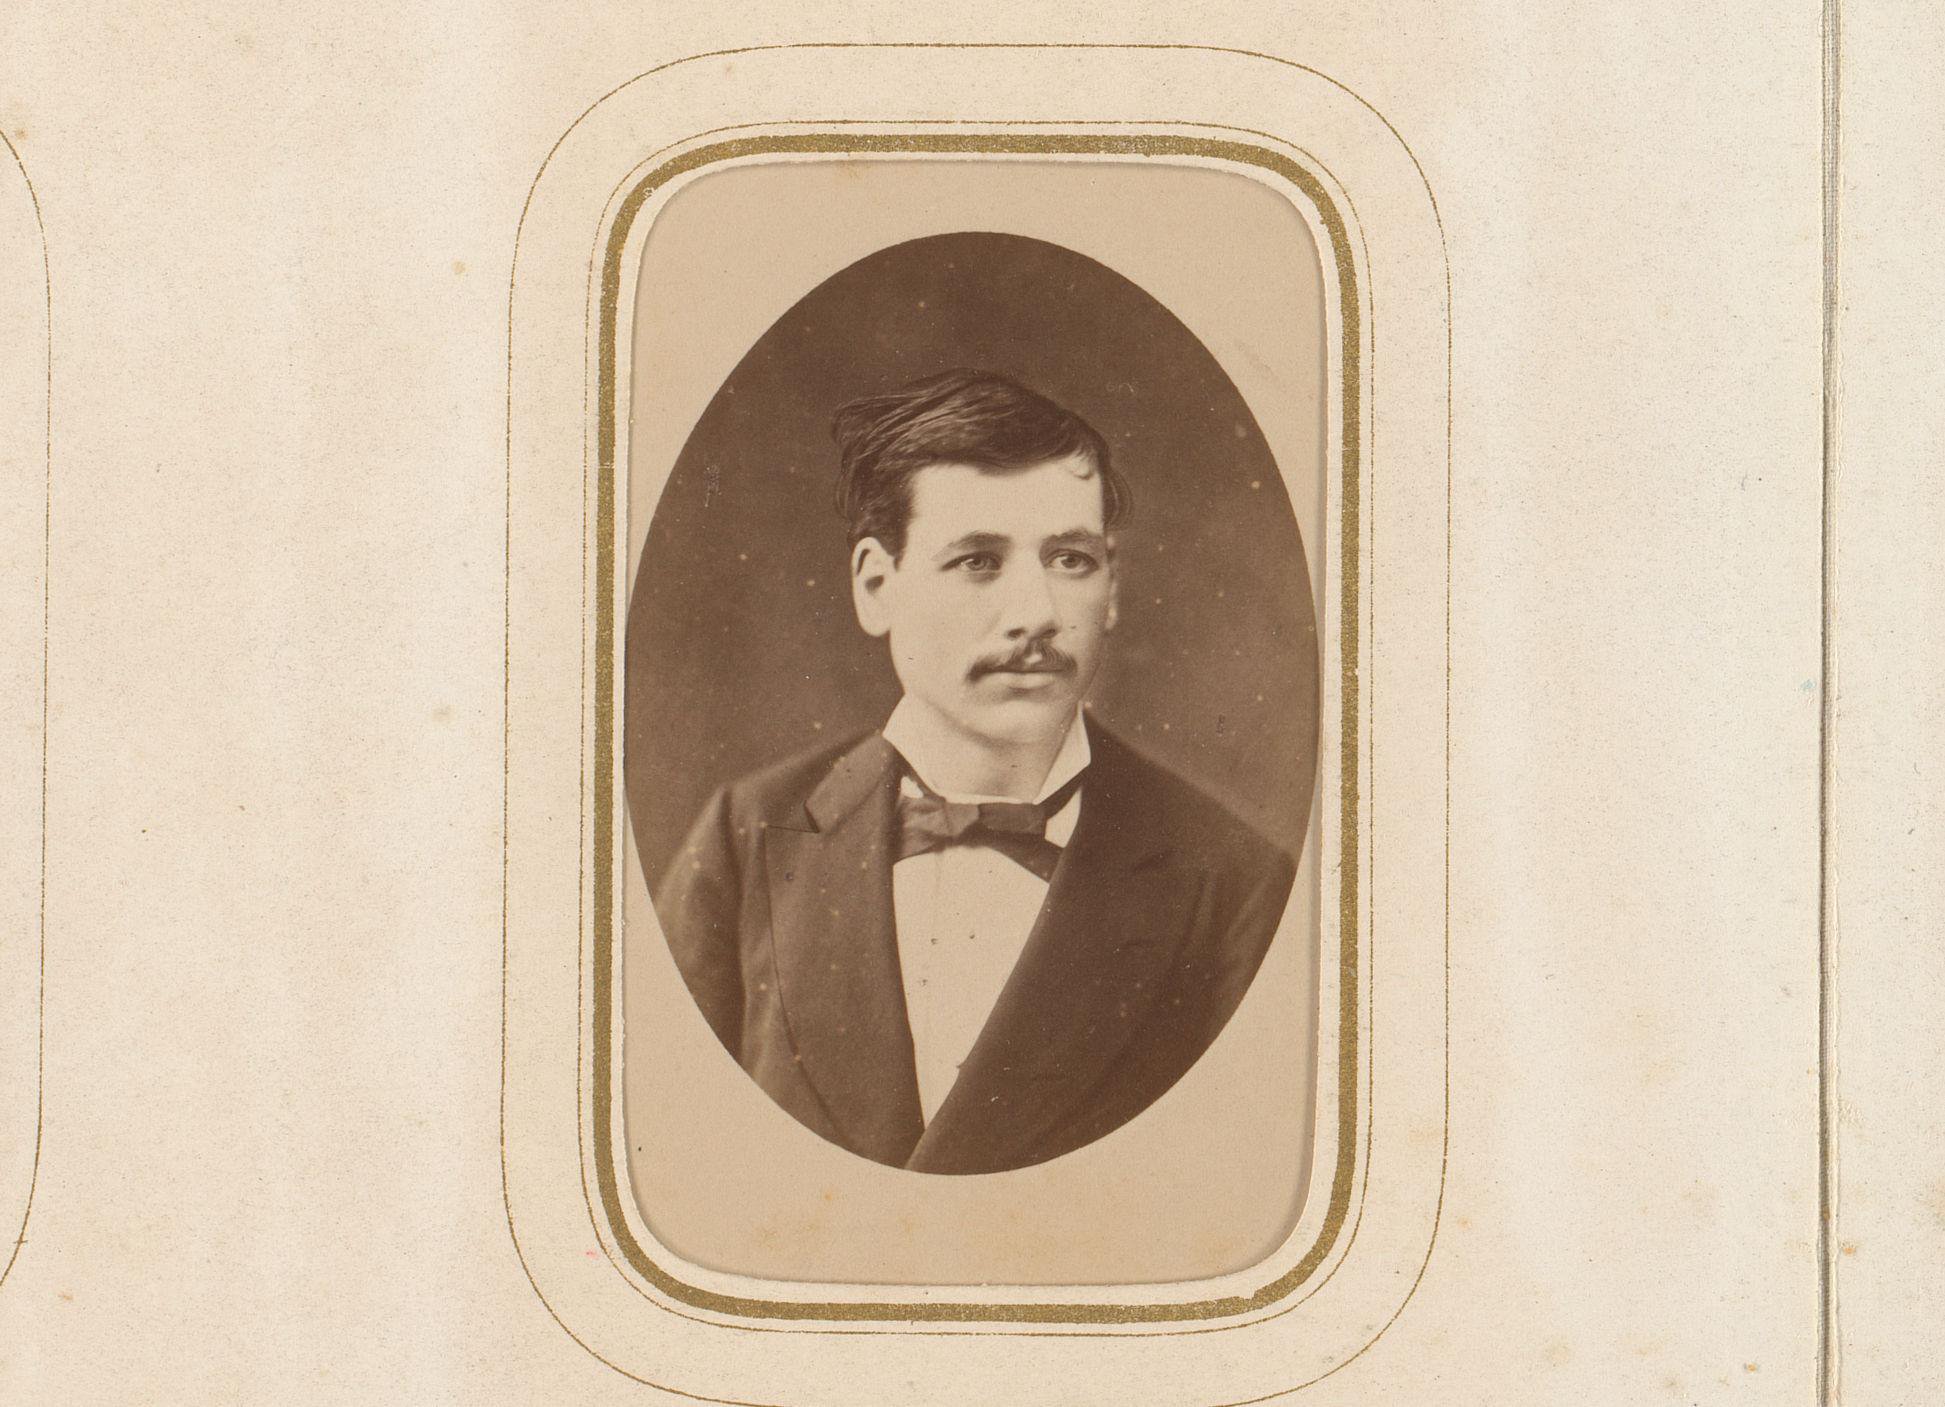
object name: carte de visite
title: Portret van een zittend kind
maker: auguste hippolyte collard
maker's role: fotograaf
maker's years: 1812-1887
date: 1867-1893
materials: cardboard, photographic support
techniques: albumen print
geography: paris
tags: moustache, historical persons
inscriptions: inscription: ‘Expositions universelles 1865-1867/ Londres 1862/ Mention Honoralbe/ Atelier Central de Photographie/ Collard/ 29, Boulevart de Strasbourg/ Paris’, inscription: ‘Collard Phot./ Des Ponts-&-Chaussées’